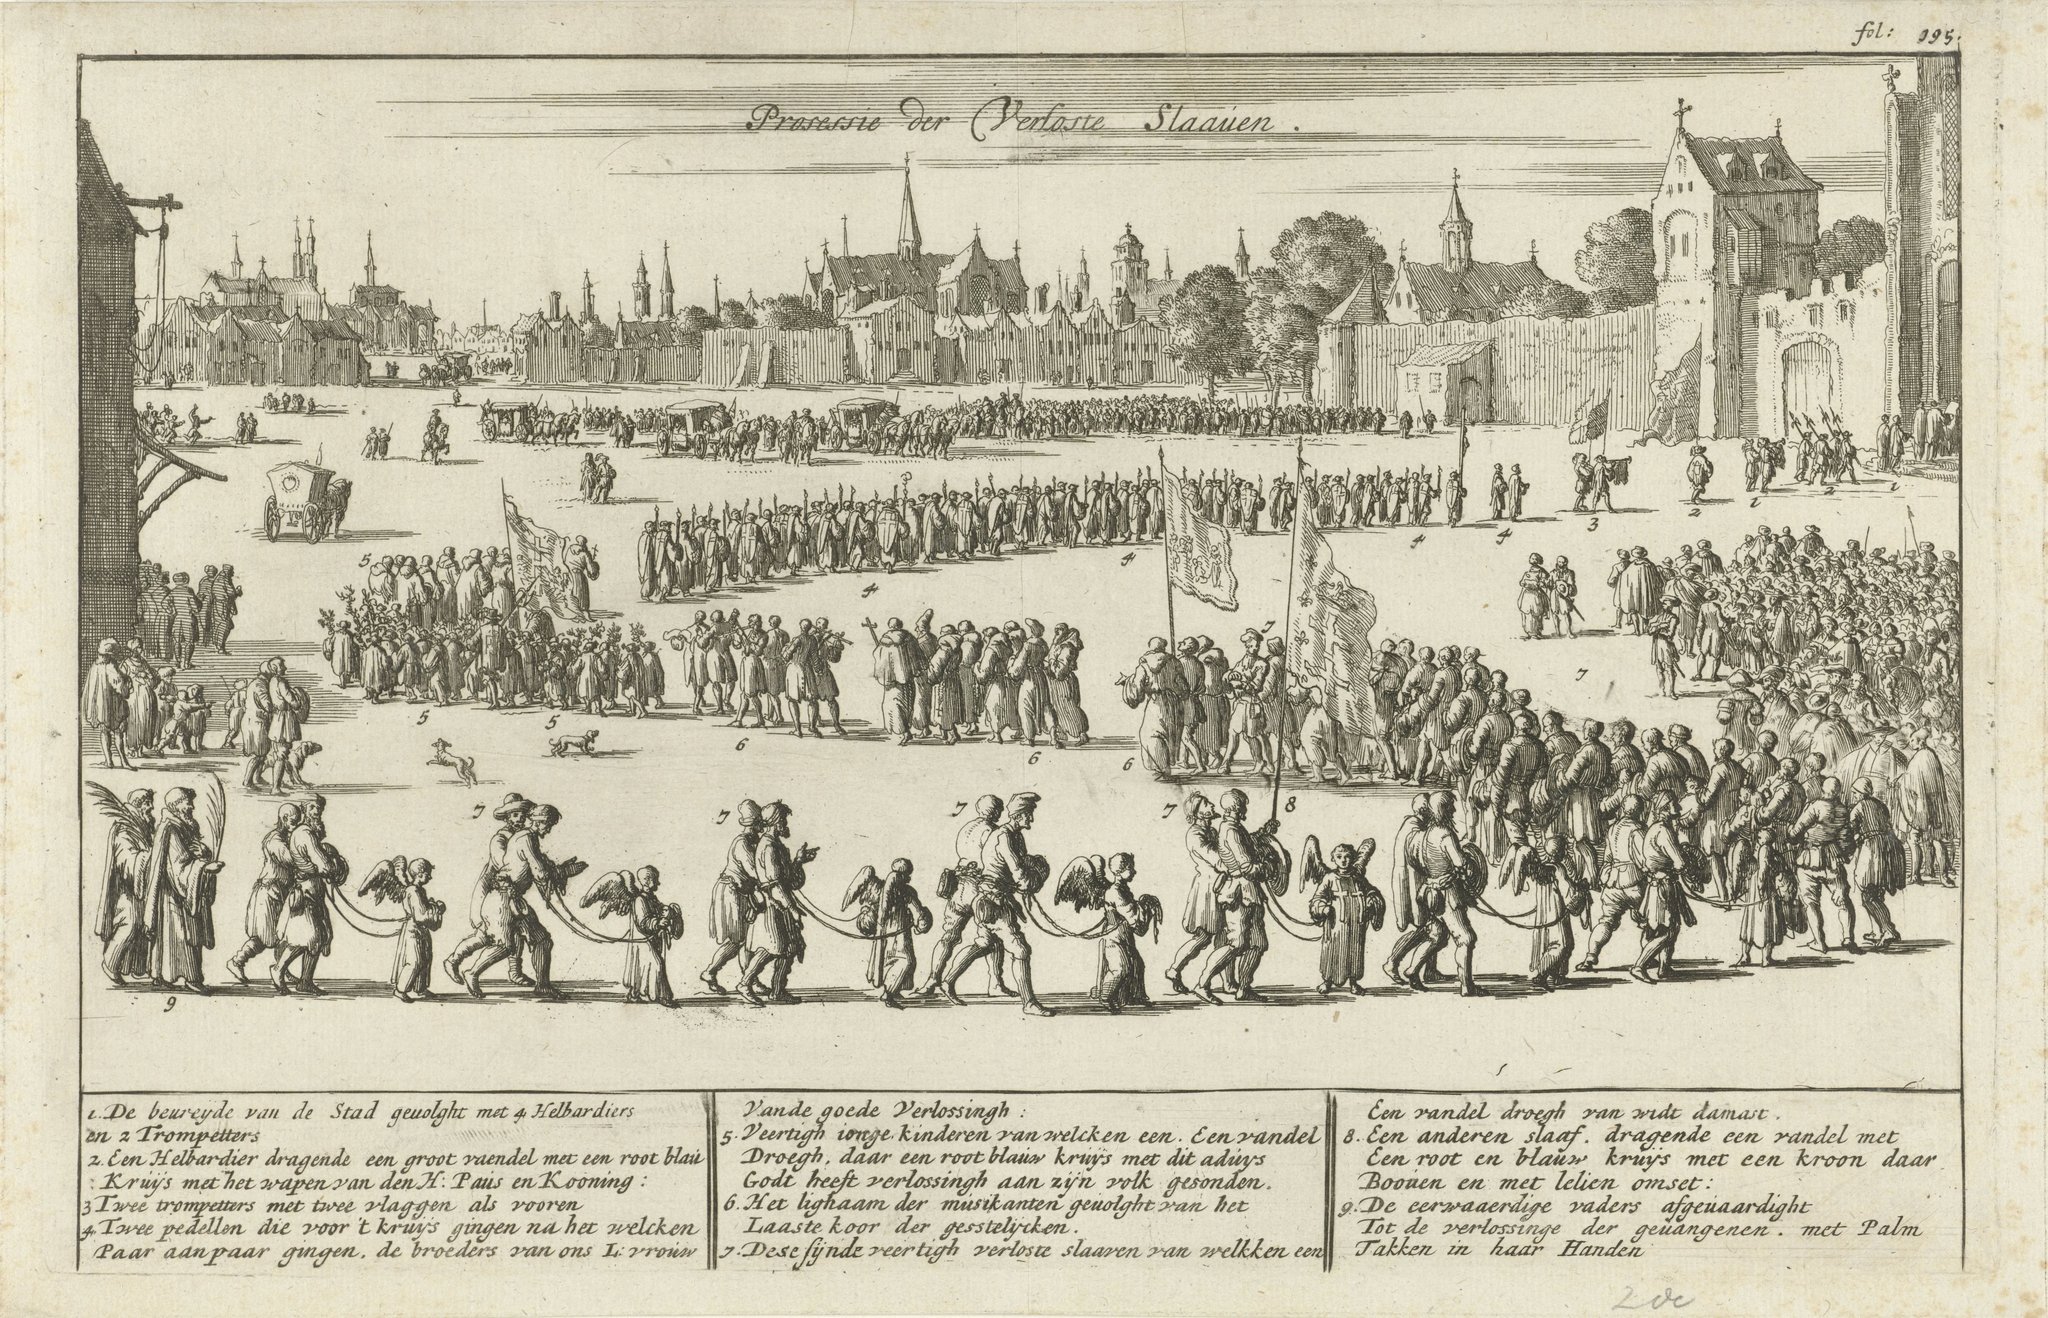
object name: book illustration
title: Prosessie der Verloste Slaaven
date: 1684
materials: paper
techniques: engraving, etching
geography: amsterdam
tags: freedom ~ slavery, procession ~ christian religion, paris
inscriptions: collector's mark: Lugt 2228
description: 40 Franse mannen, waarvan een deel in Tunis in slavernij verkeerde en een deel door Algerijnse kapers gevangen was genomen, zijn in Tunis vrijgekocht door de Orde der Trinitariërs. Dergelijke slaafgemaakten stonden bekend als 'christenslaven'. Ter ere van hun vrijkoping worden ze in Parijs in een processie door de stad gevoerd. In het onderschrift de legenda 1-9. Rechtsboven genummerd: fol: 195.